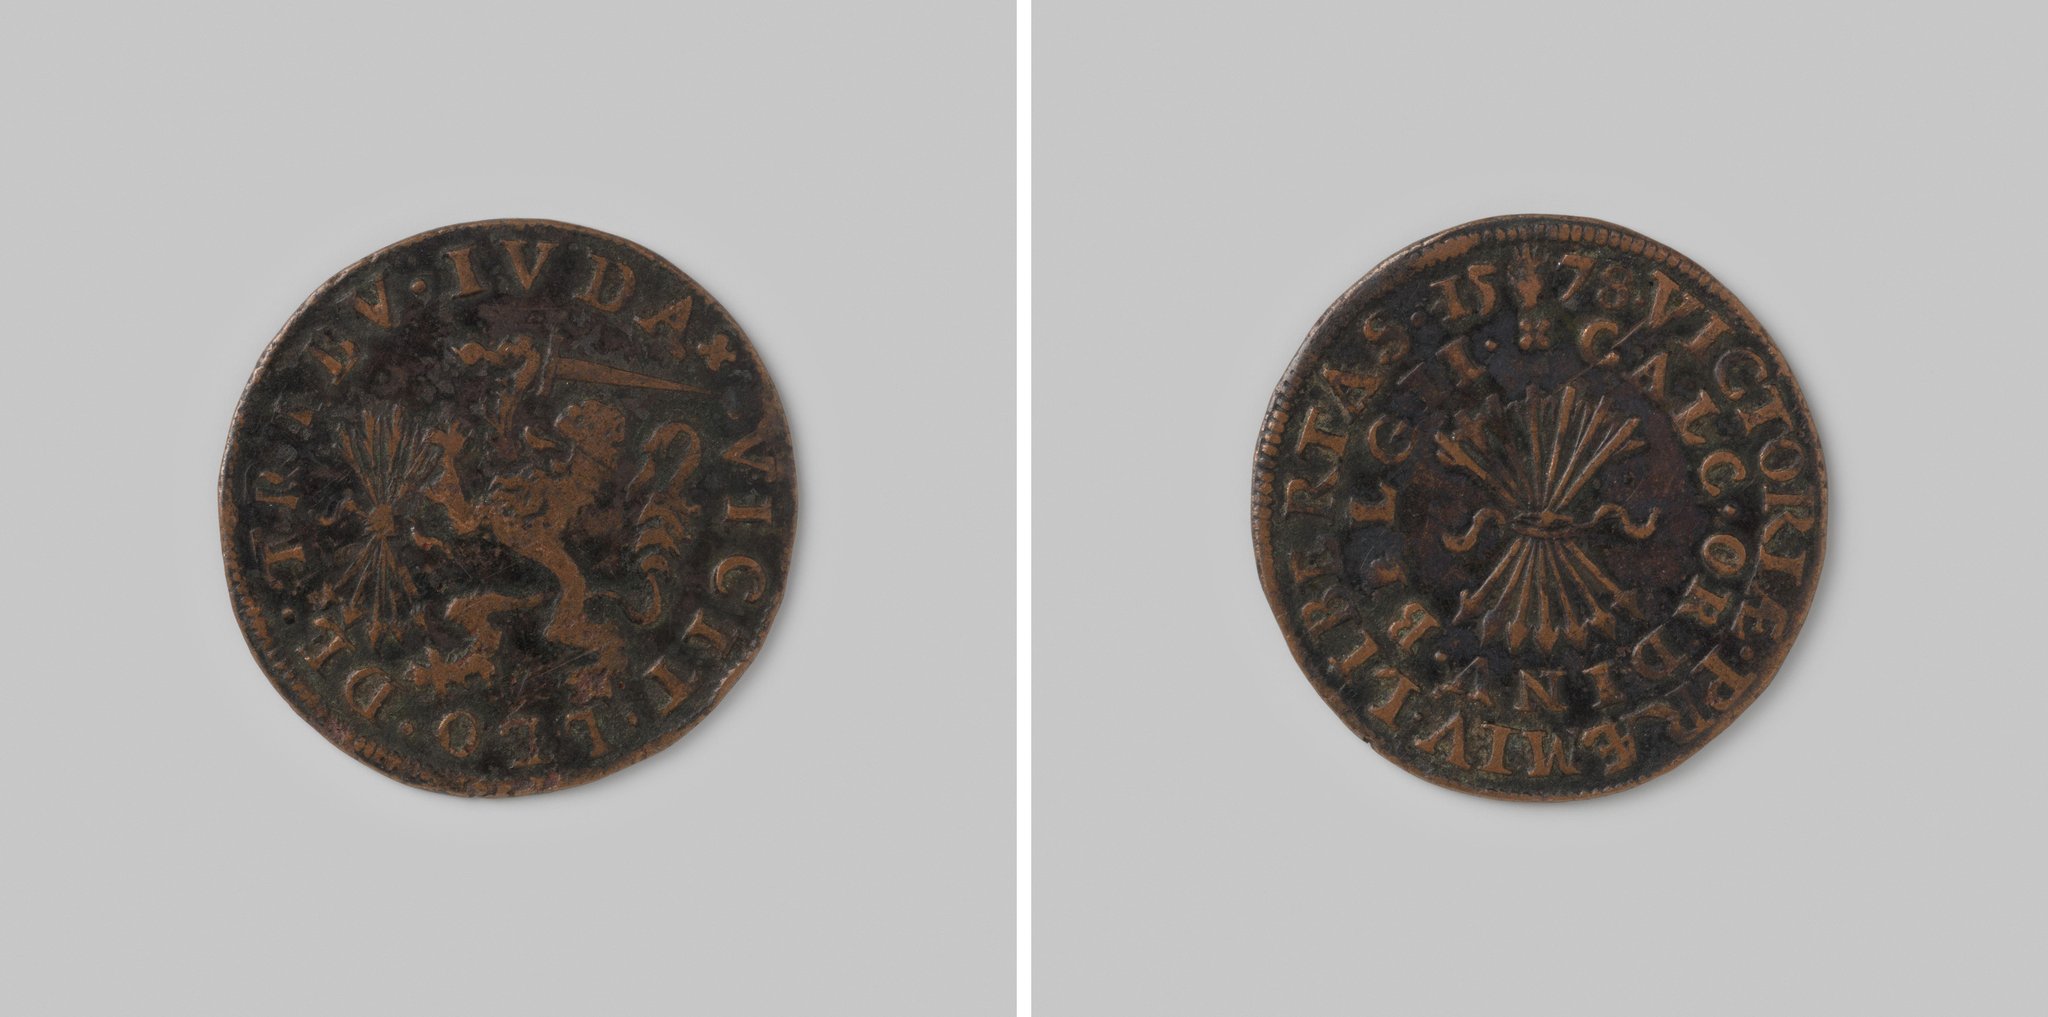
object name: history medal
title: Rekenpenning uit Antwerpen voor de Nederlandse Staten op de Unie van Utrecht 1578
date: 1578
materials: copper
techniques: striking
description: Koperen penning, op de voorzijde een klimmende leeuw naar links met zwaard en pijlenbundel, met omschrift, op de keerzijde een pijlenbundel met dubbel omschrift.